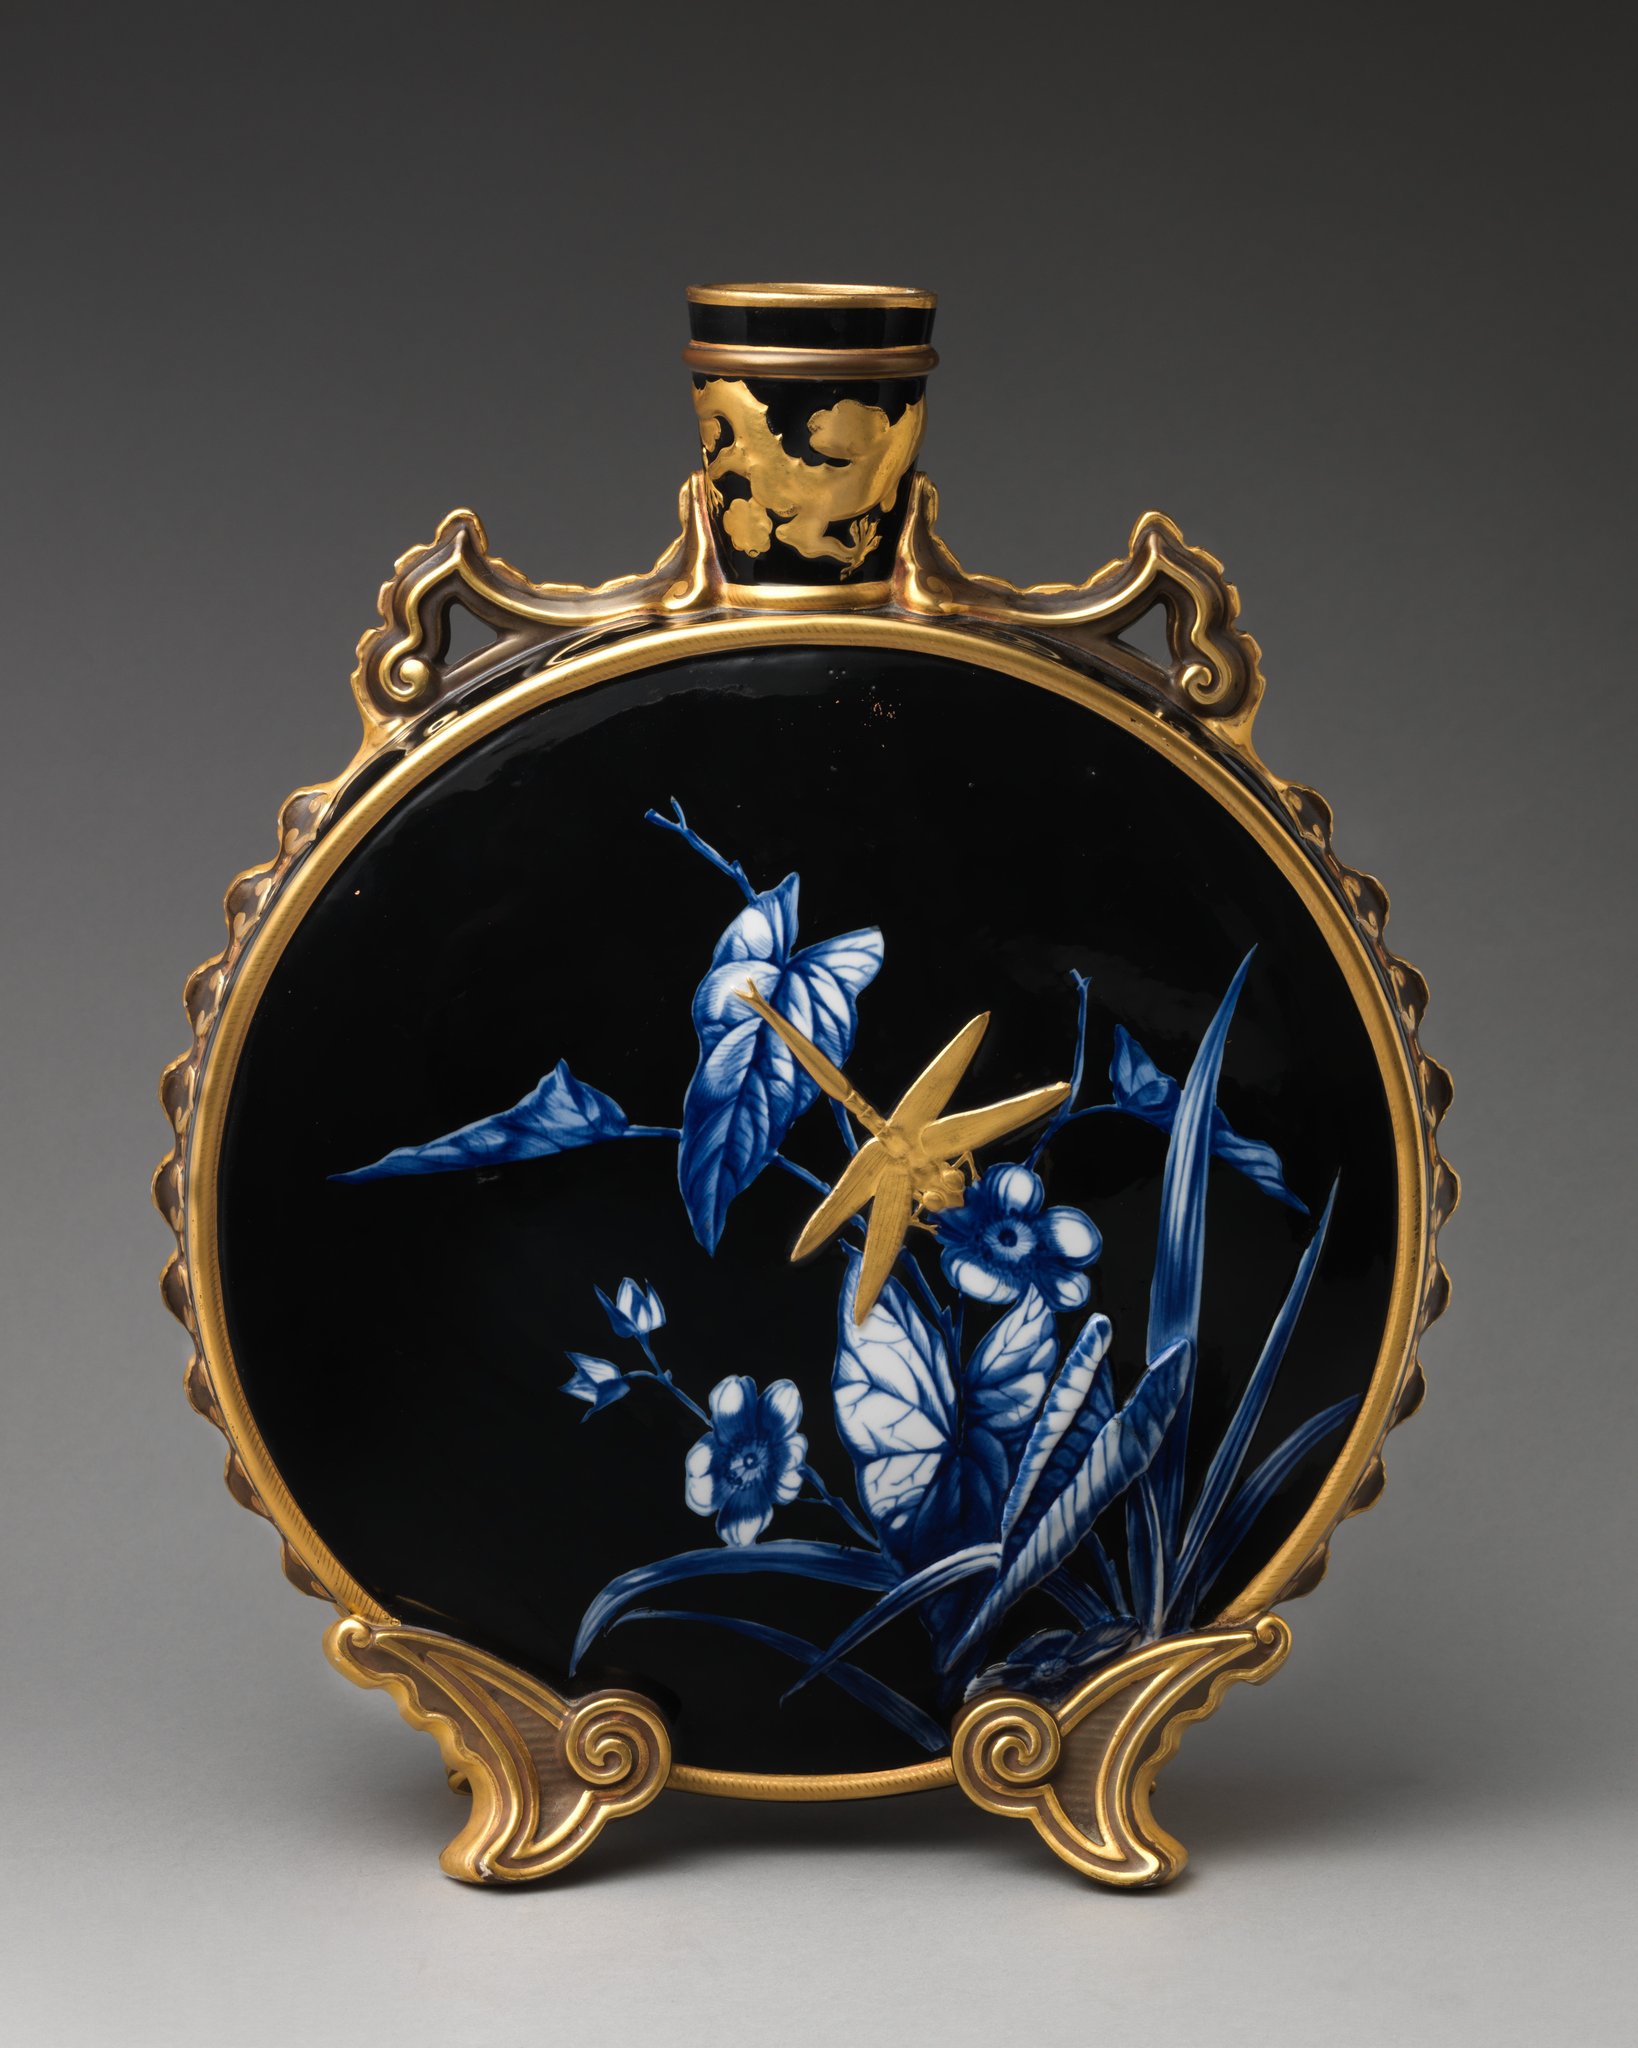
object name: moon flask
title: Moon flask with gold dragonfly motif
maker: worcester factory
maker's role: maker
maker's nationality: british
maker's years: 1751-2008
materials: porcelain